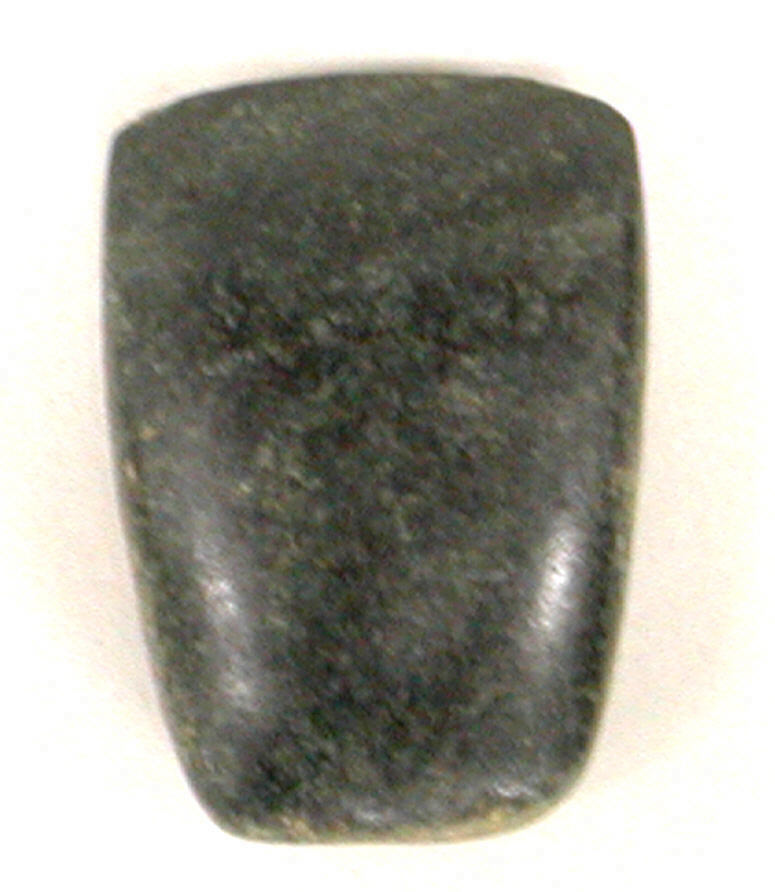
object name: celt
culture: maya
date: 1501-1600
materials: stone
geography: guatemala